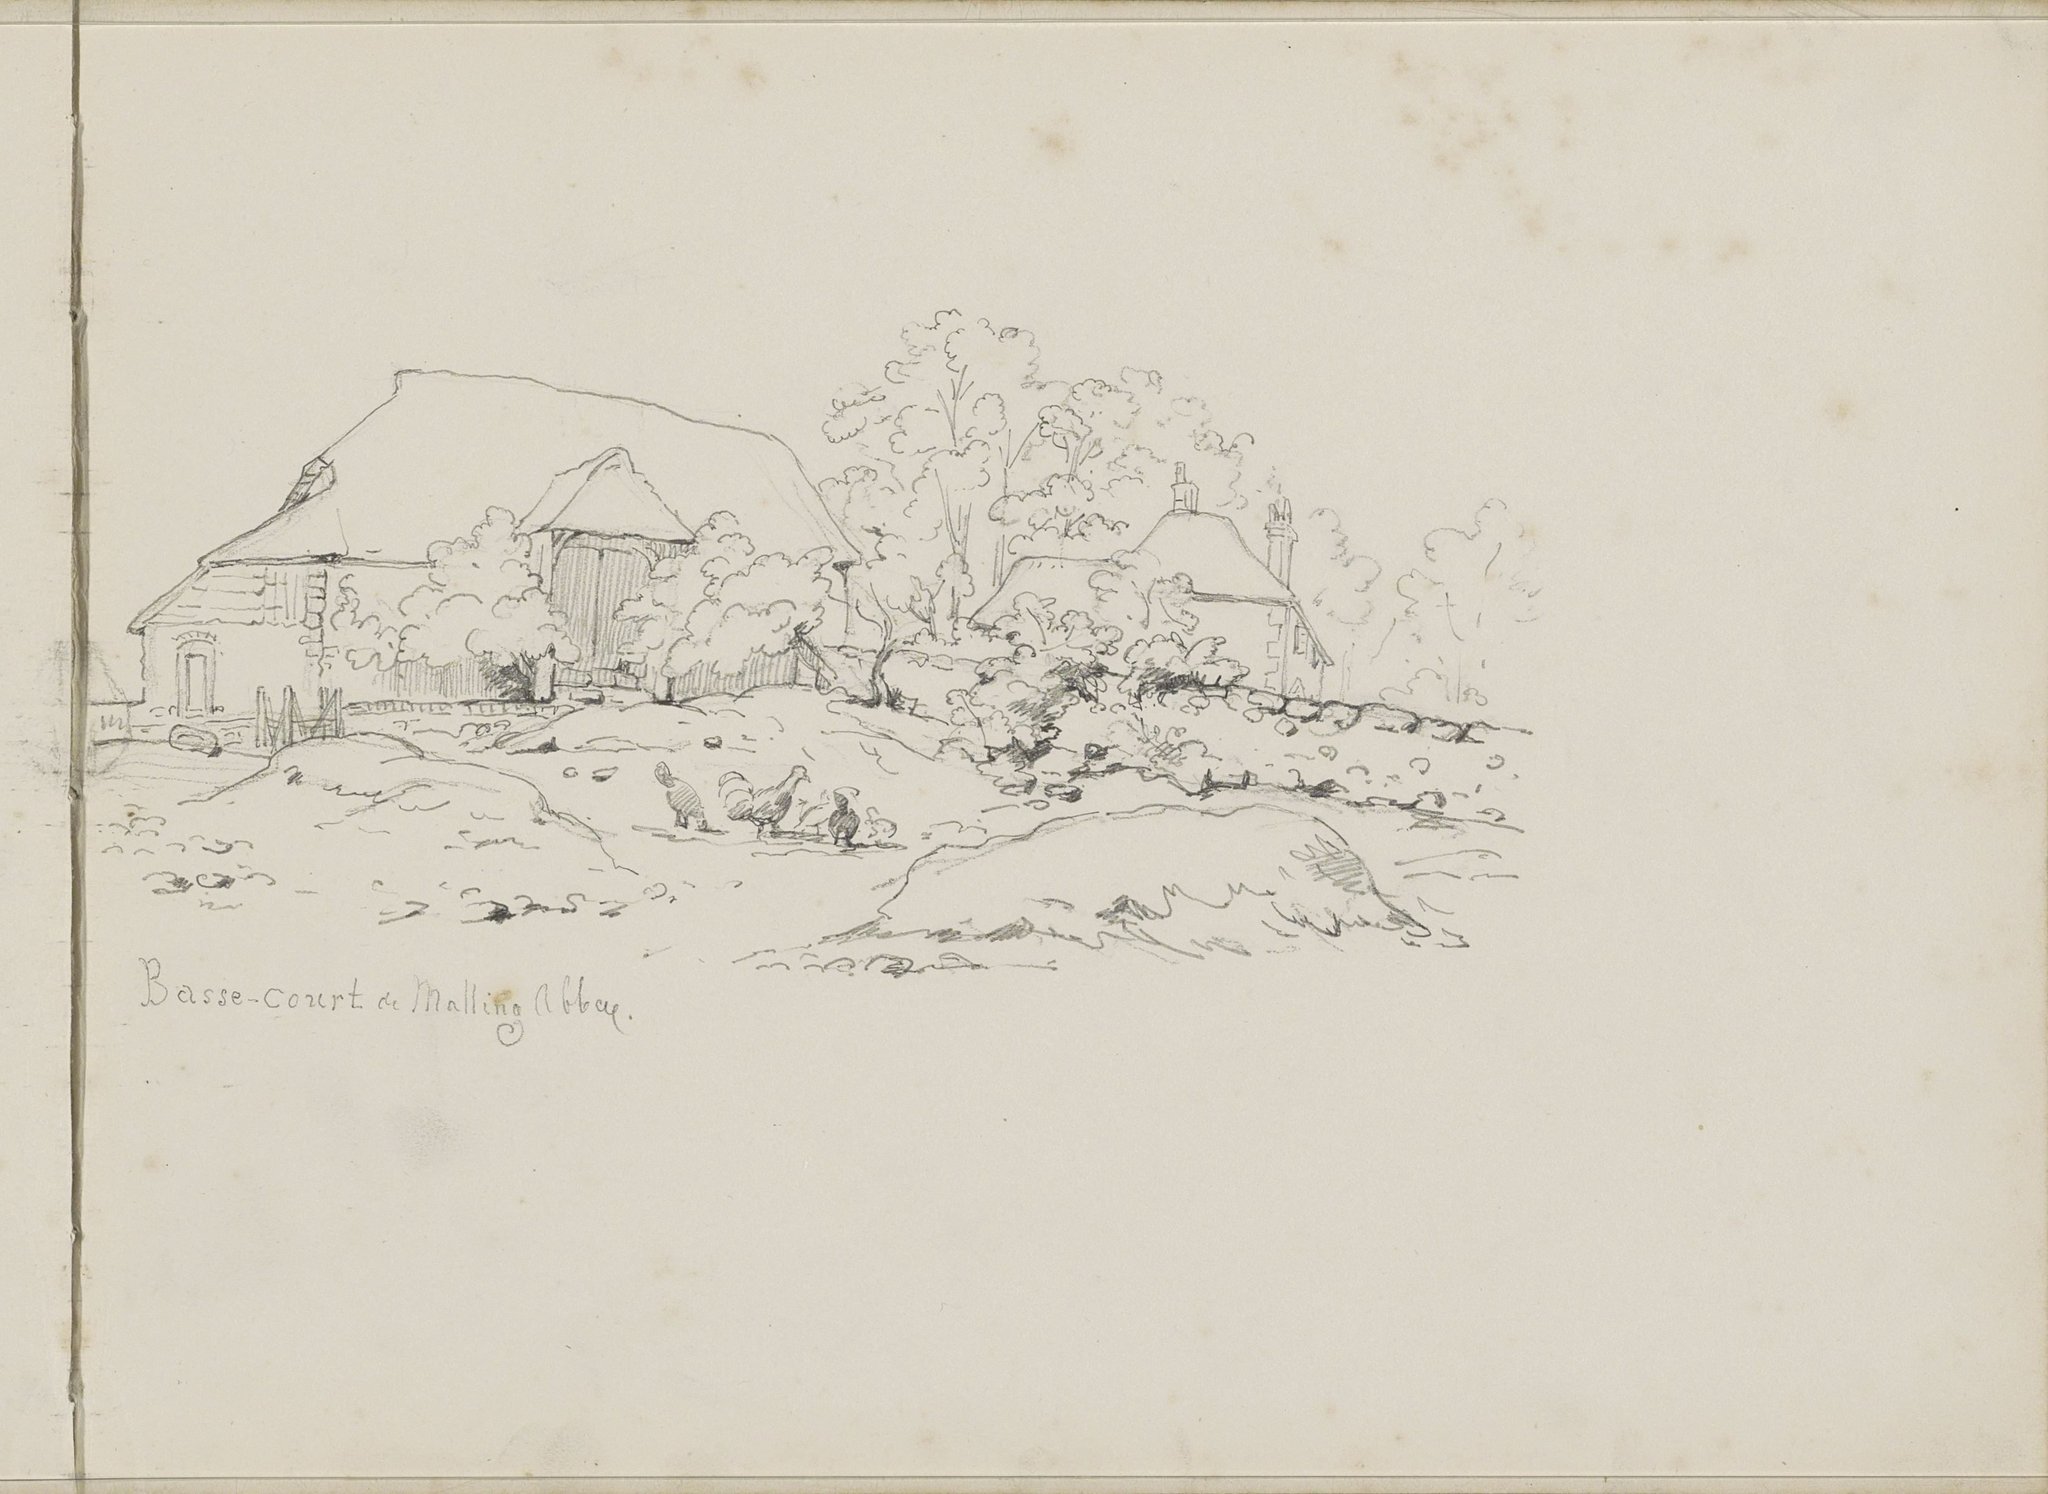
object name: sketchbook leaf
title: Achtertuin van Malling Abbey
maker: gerrit postma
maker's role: draughtsman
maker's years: 1819-1894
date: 1858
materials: paper, pencil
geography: west malling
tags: fowl (cock, hen, chicken, etc.)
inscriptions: annotation: ‘Basse-court de Malling Abbey.’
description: In de tuin scharrelen kippen. Blad 40 recto uit een schetsboek met 52 bladen.